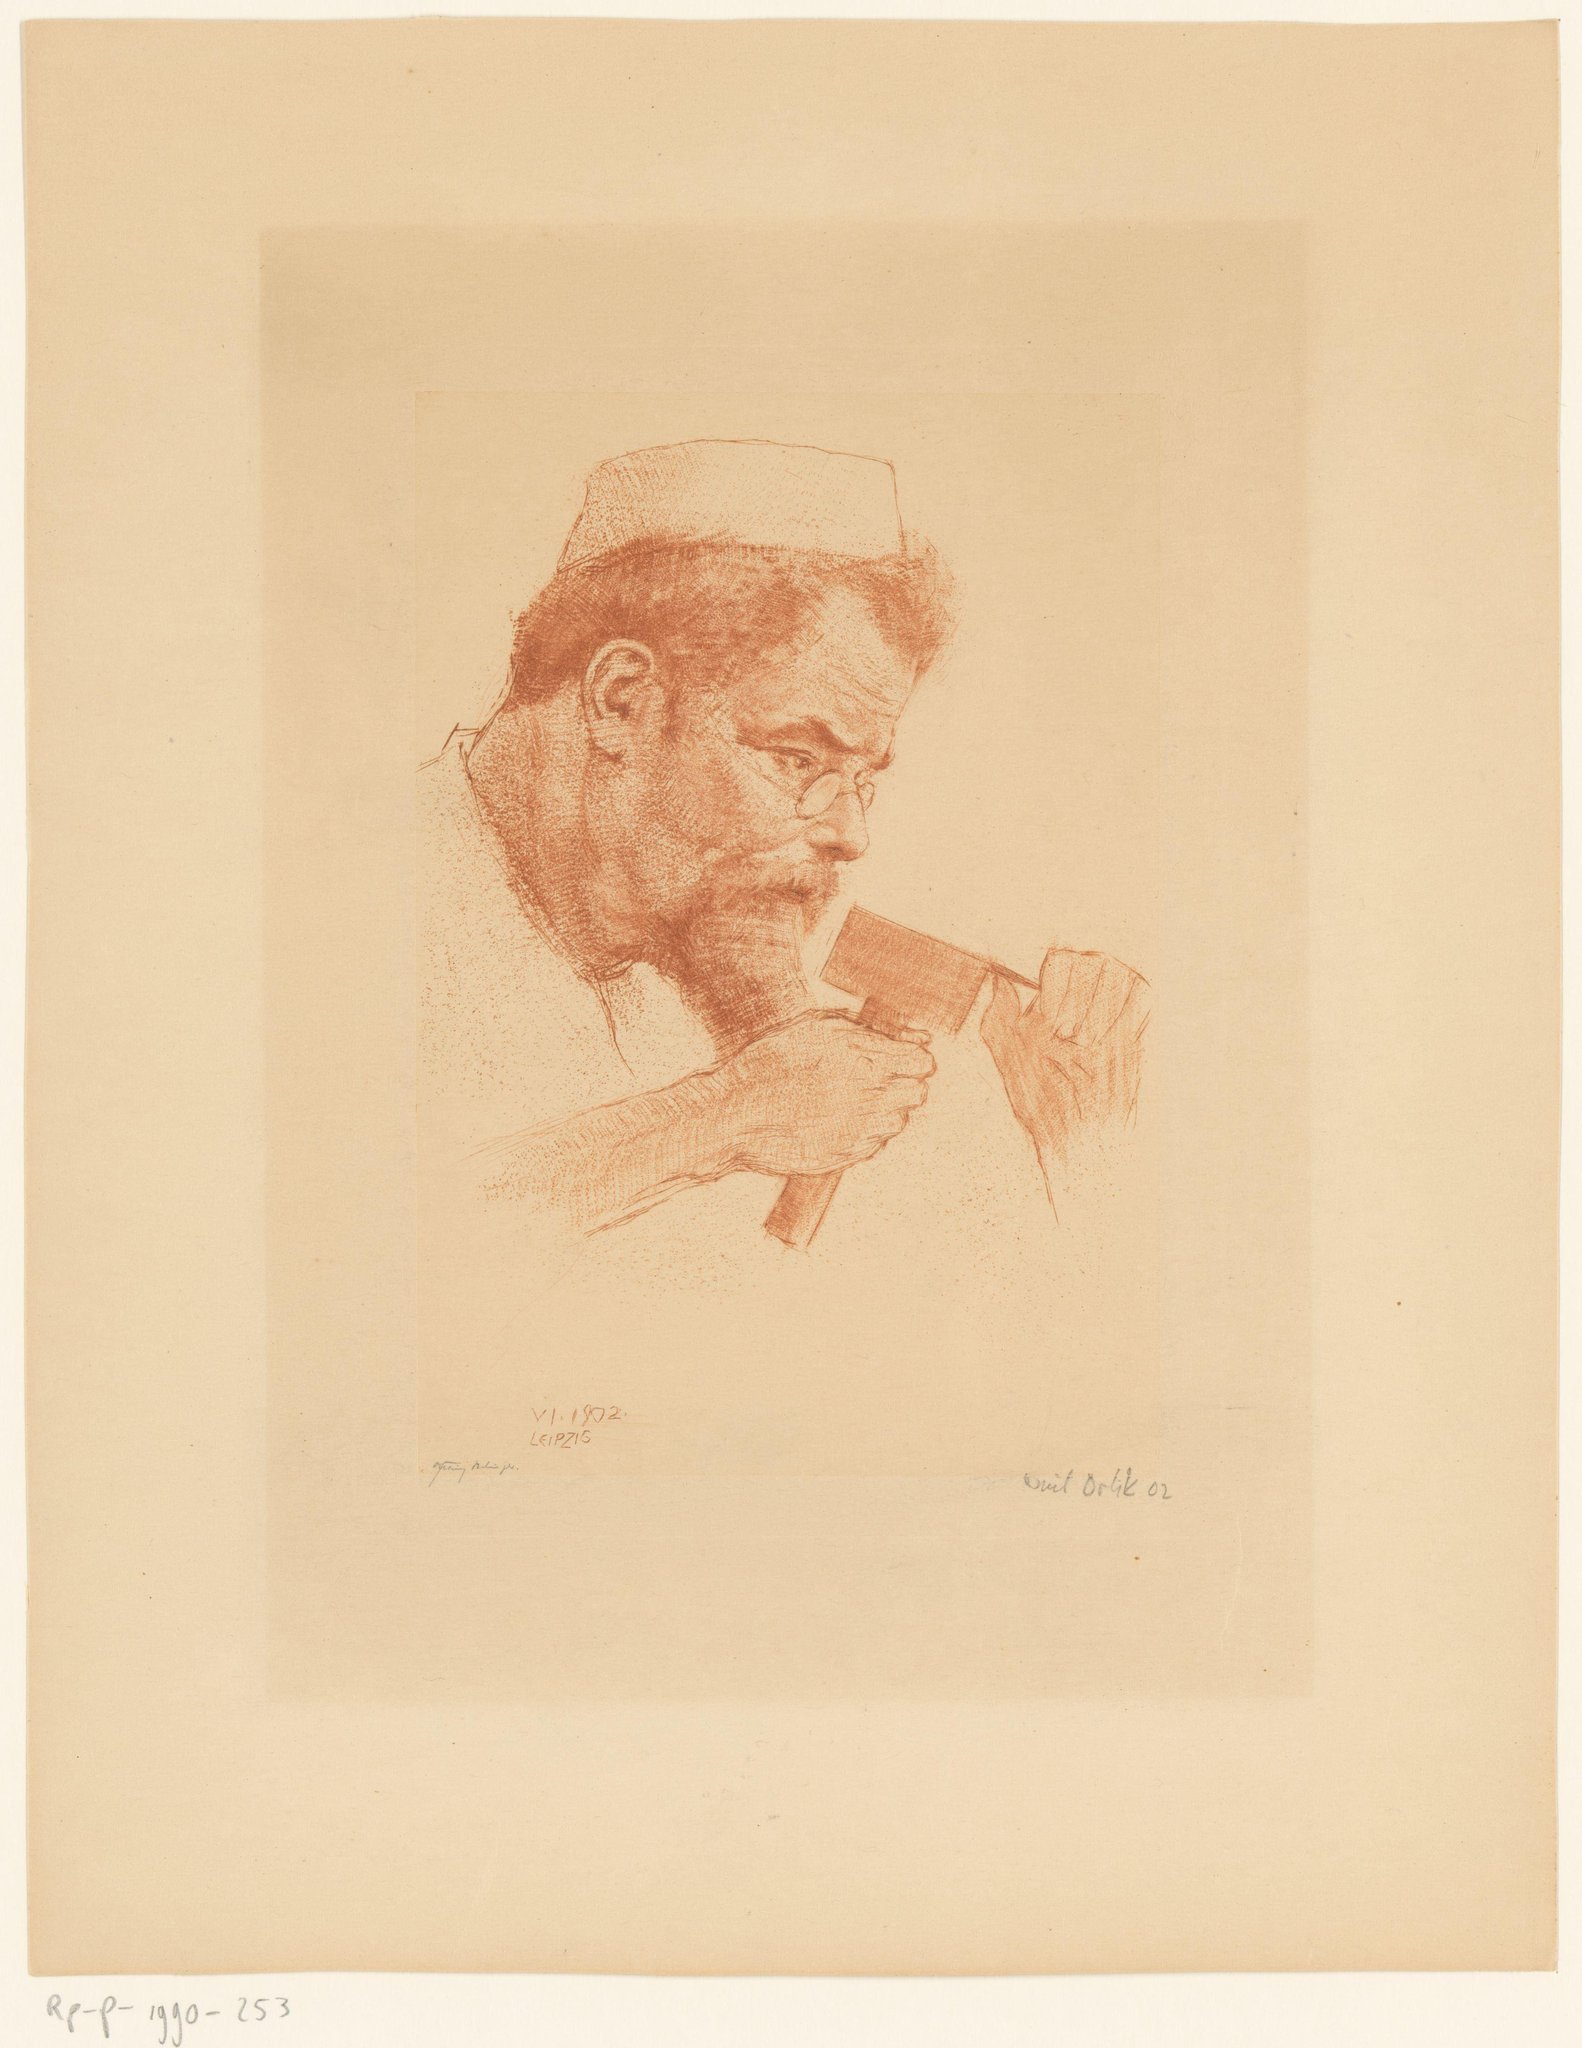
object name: print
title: Portret van Max Klinger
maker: emil orlik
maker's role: painter, print maker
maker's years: 1870-1932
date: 1902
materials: paper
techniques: etching, roulette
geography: leipzig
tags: print maker, max klinger, historical persons, tools, implements of graphic artist, portrait, self-portrait of graphic artist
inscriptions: collector's mark: Lugt 2228, collector's mark: Lugt 2760, name, name: ‘Emil Orlik 02’